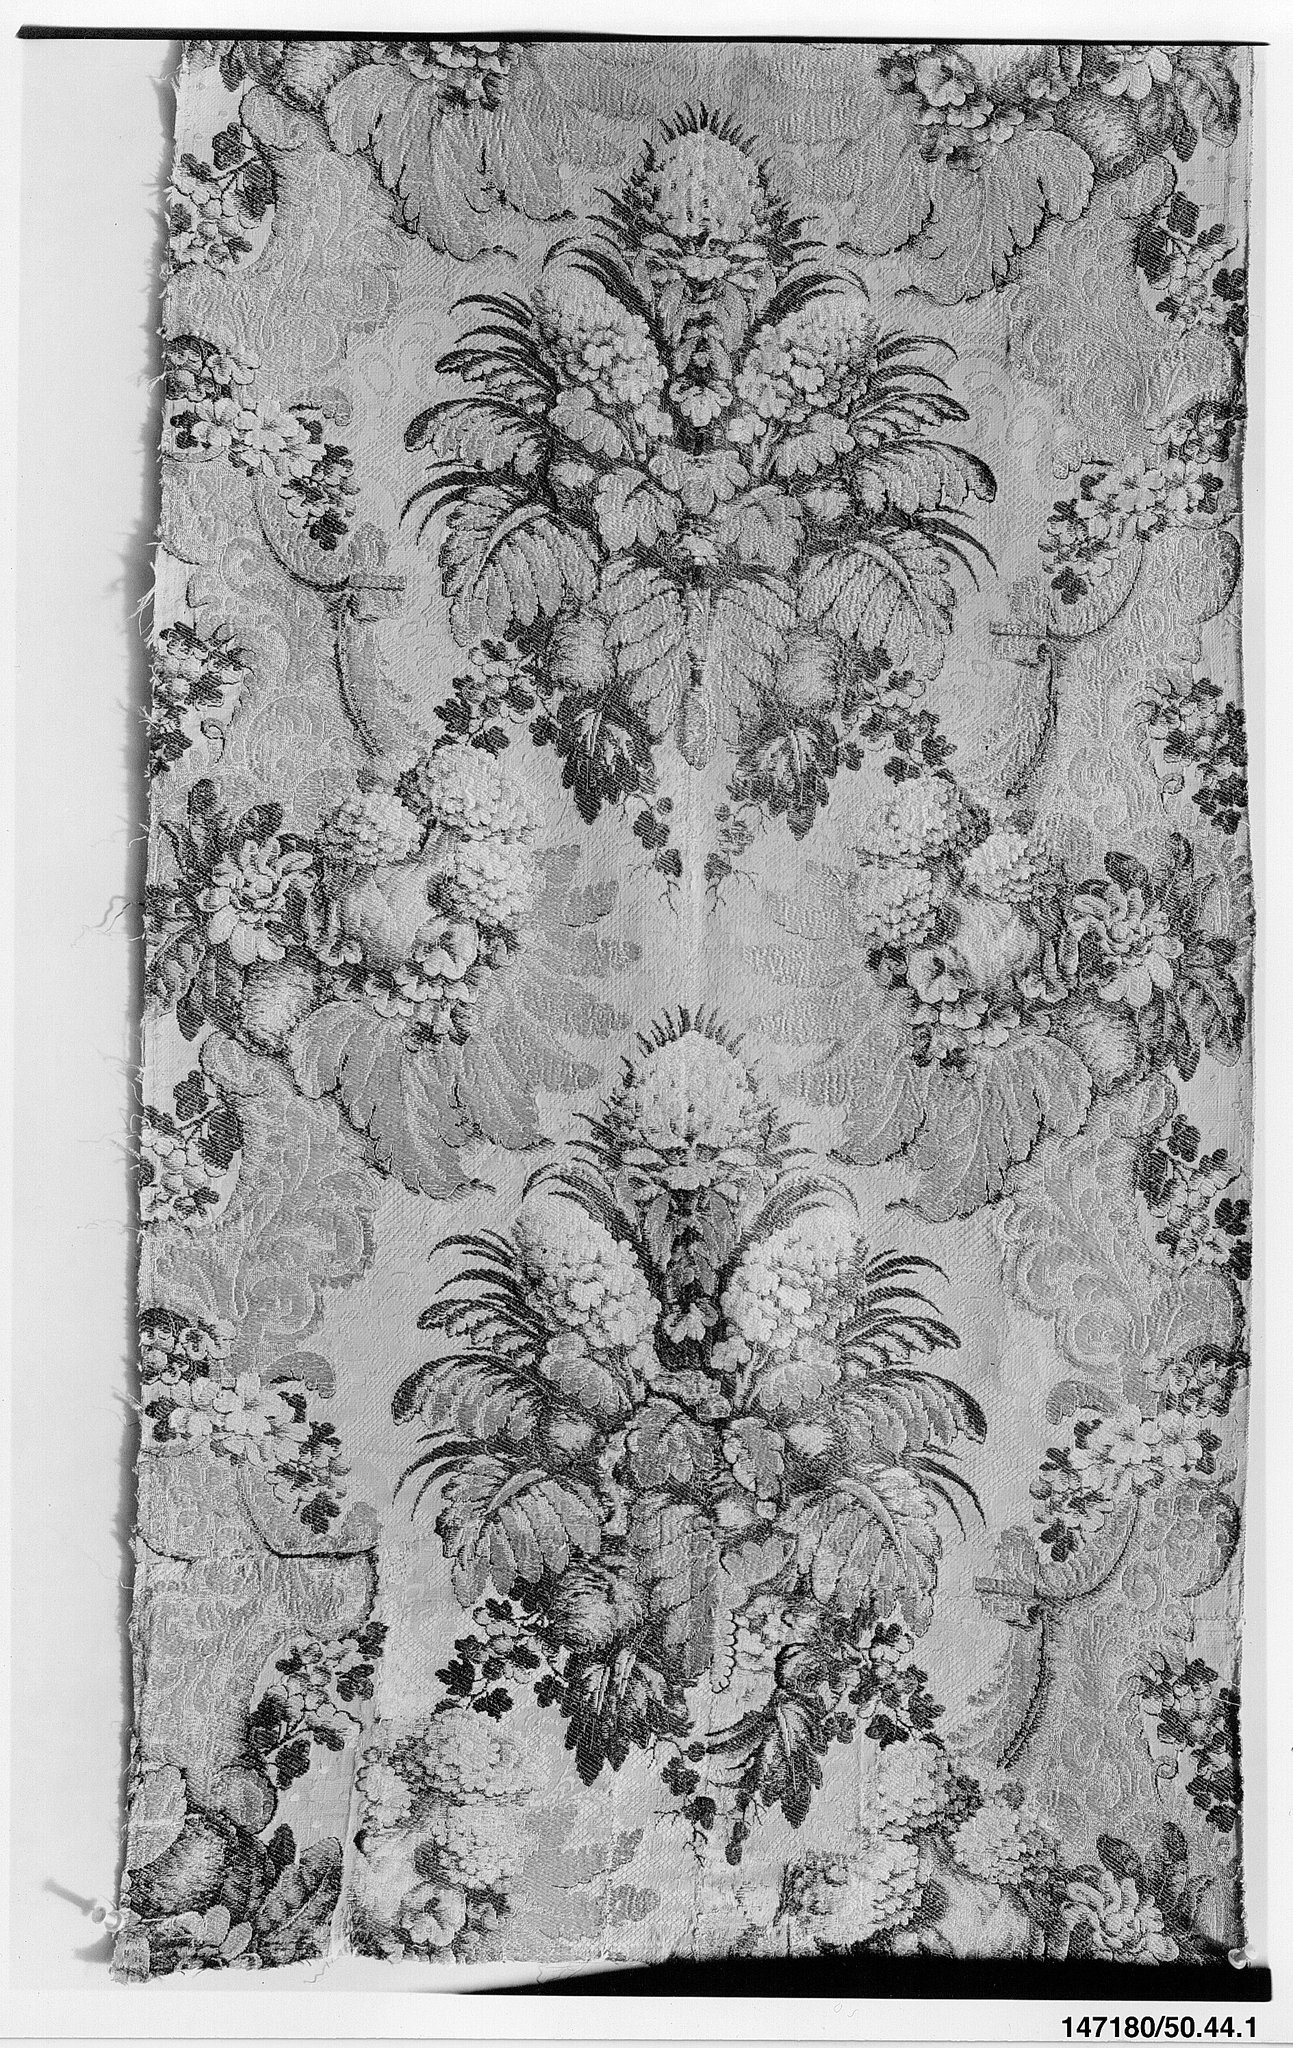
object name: piece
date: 1701-1800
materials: metal thread, silk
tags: flowers,leaves